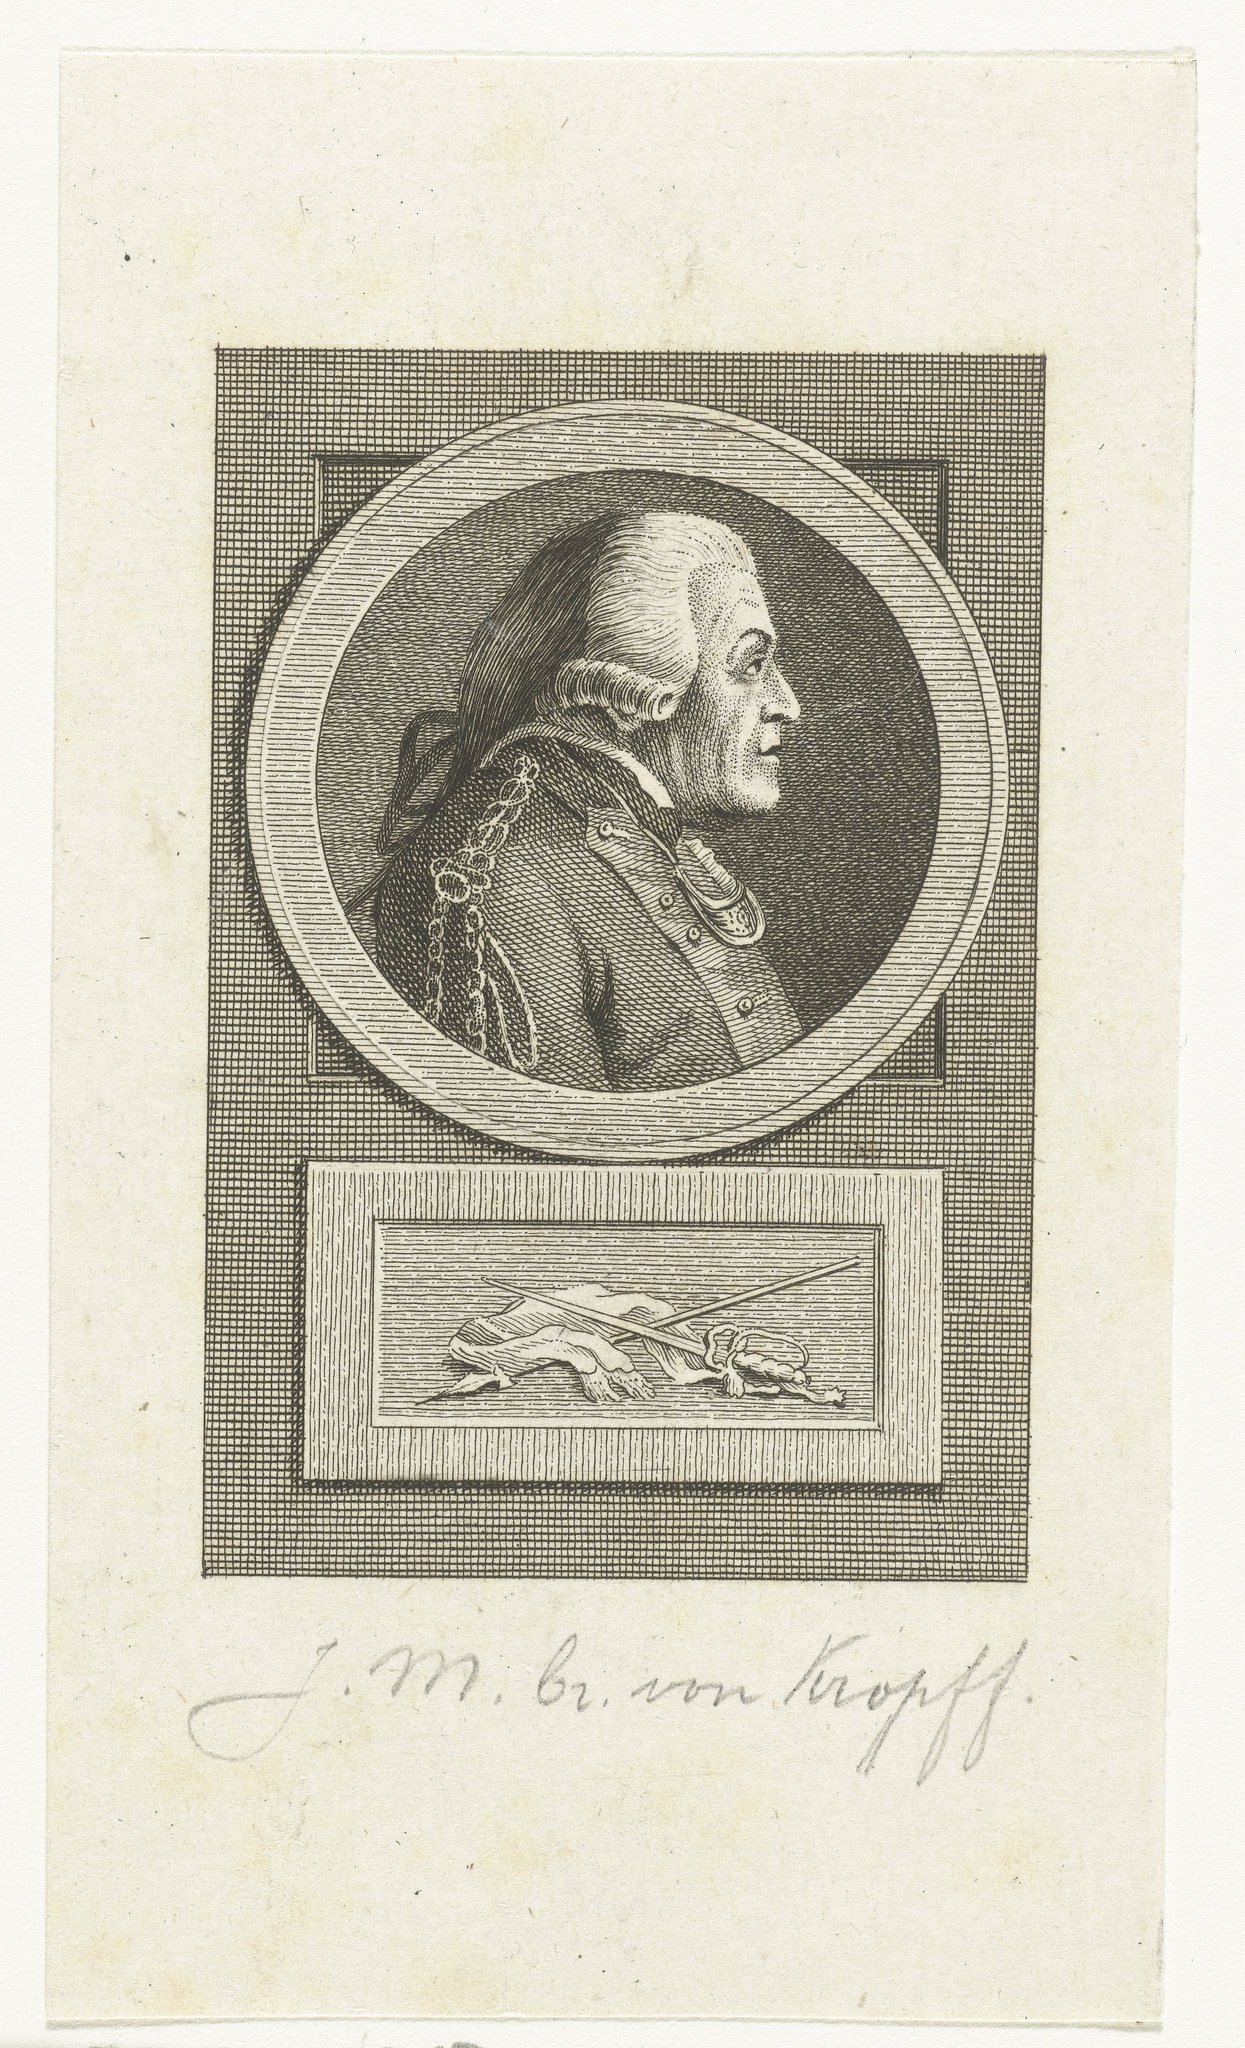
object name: print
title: Portret van Joachim Maurits baron van Kropff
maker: cornelis bogerts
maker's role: print maker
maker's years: 1745-1817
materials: paper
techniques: etching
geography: amsterdam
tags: commandant, joachim maurits baron van kropff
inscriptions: collector's mark: Lugt 2228